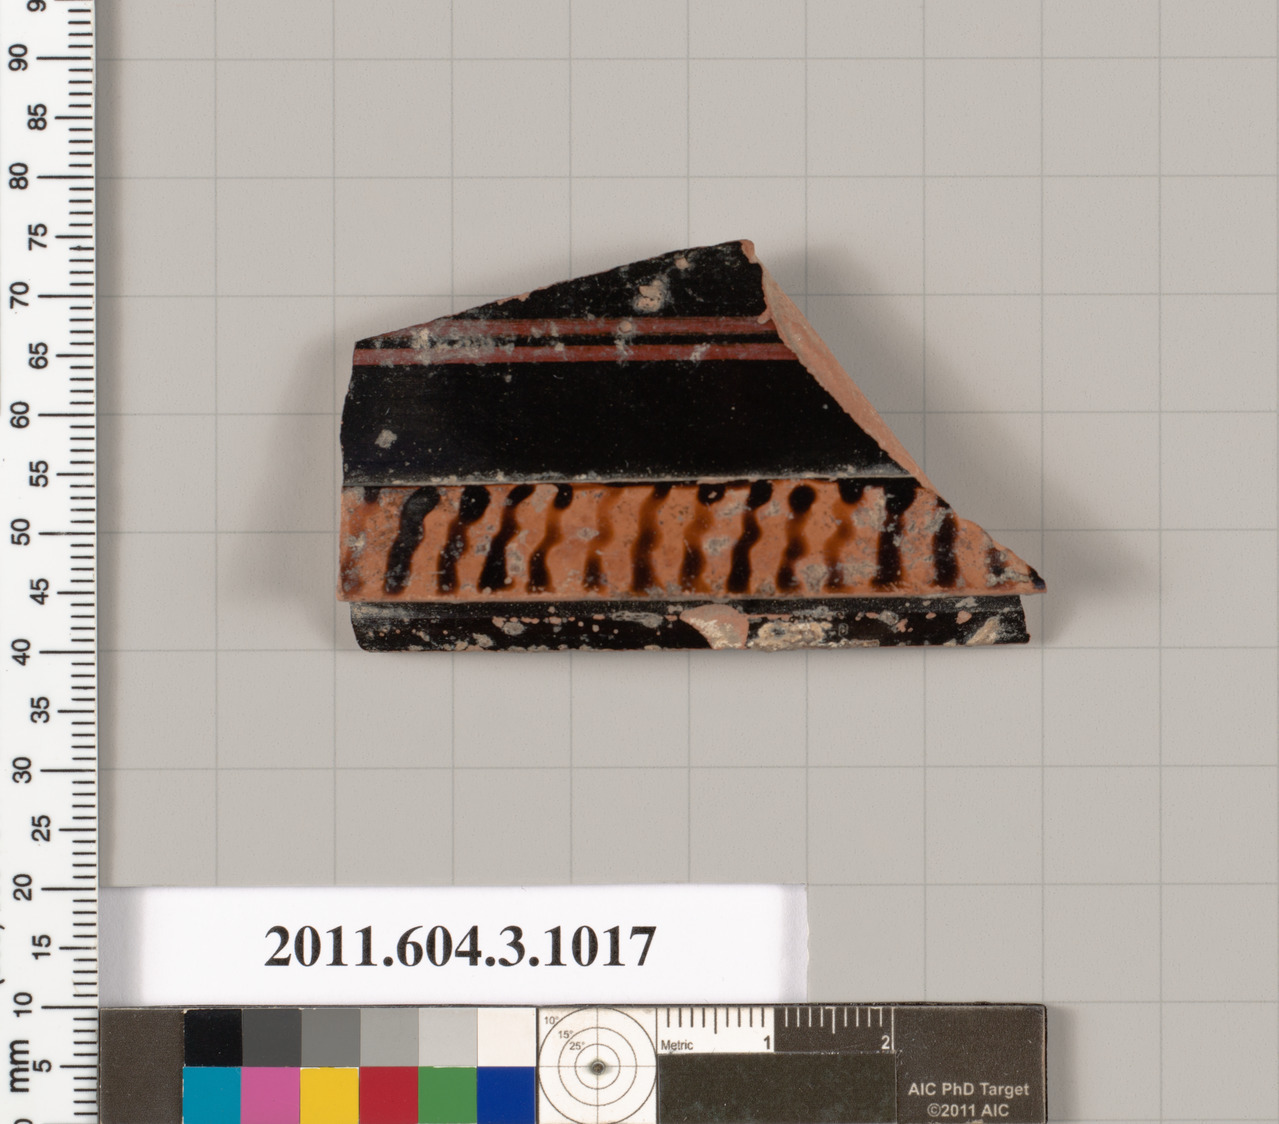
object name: lekanis fragment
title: Terracotta fragment of a lekanis (covered dish)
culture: greek, attic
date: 475-451 BCE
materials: terracotta